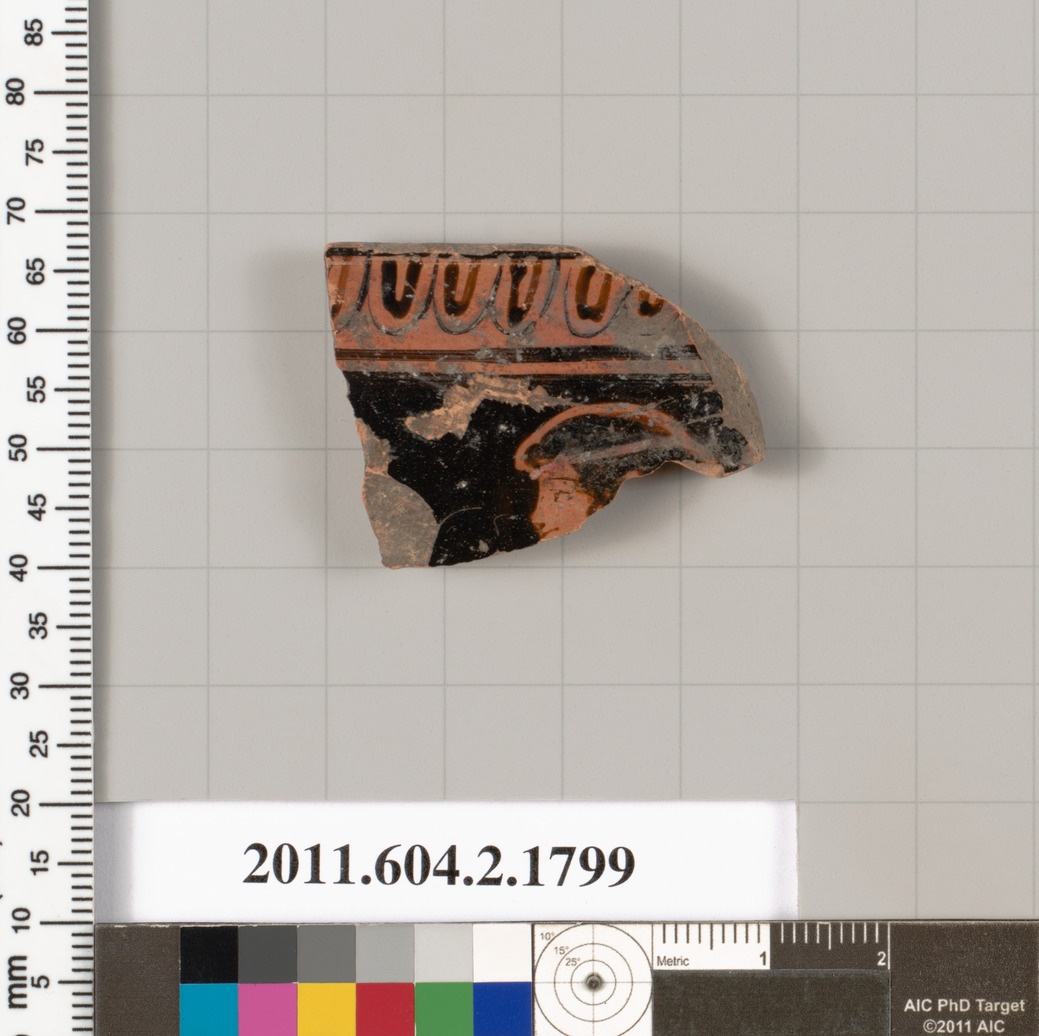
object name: skyphos fragment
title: Terracotta rim fragment of a skyphos (deep drinking cup)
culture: greek, attic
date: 450-440 BCE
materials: terracotta